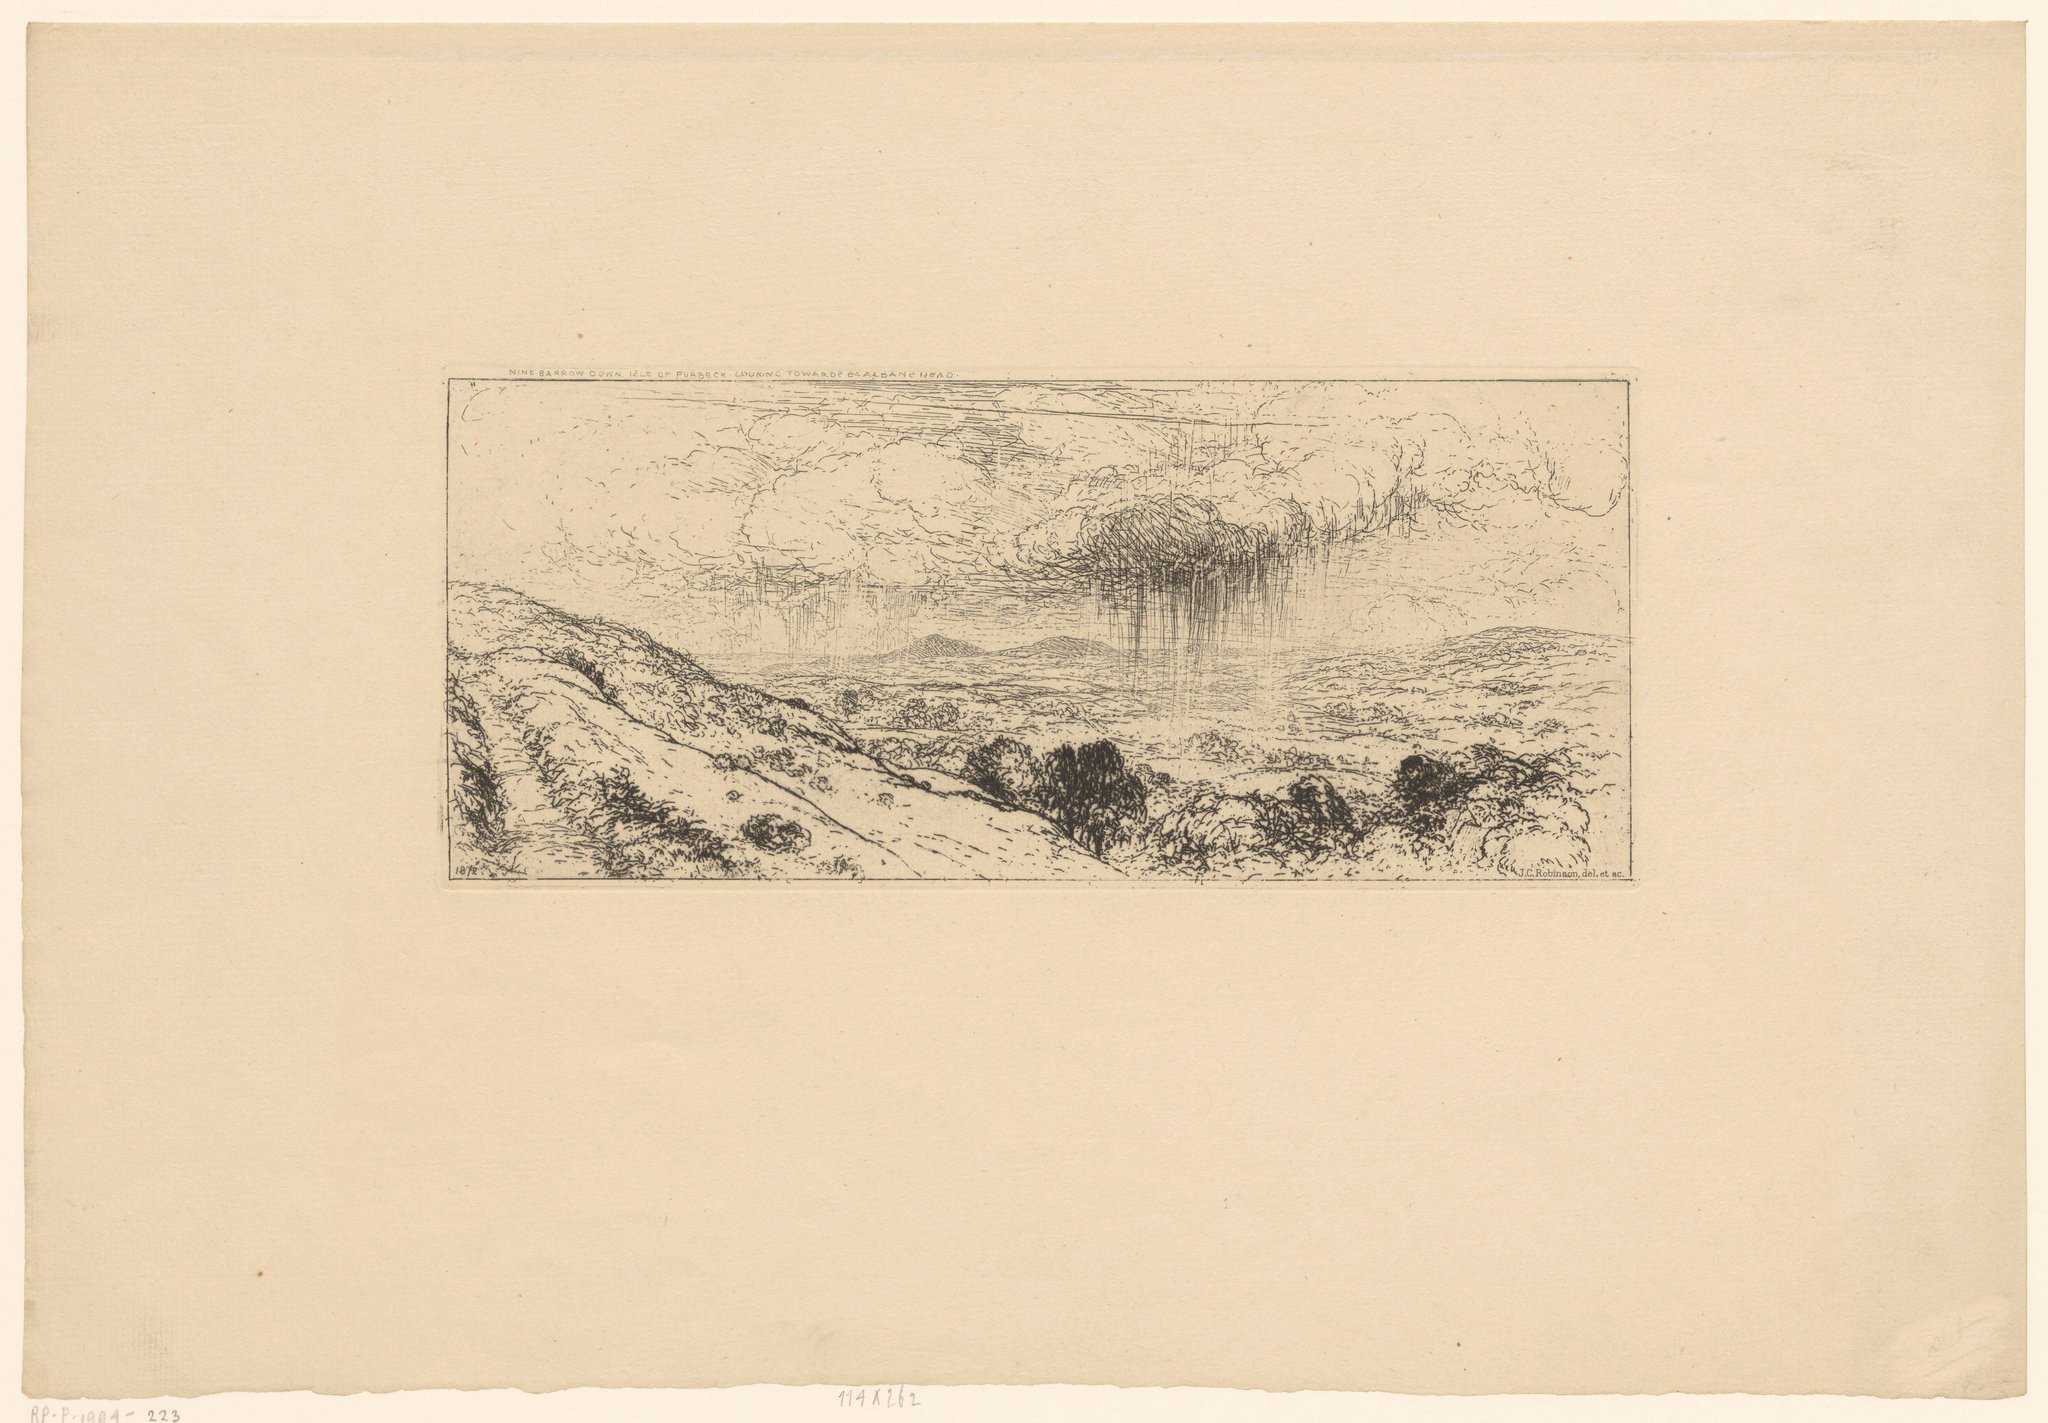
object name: print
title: Nine Barrow Down, Isle of Purbeck, looking towards St Alban's Head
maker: john charles robinson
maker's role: print maker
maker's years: 1824-1913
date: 1872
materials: paper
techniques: drypoint, etching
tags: downpour, rain shower, low hill country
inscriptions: collector's mark: Lugt 2228